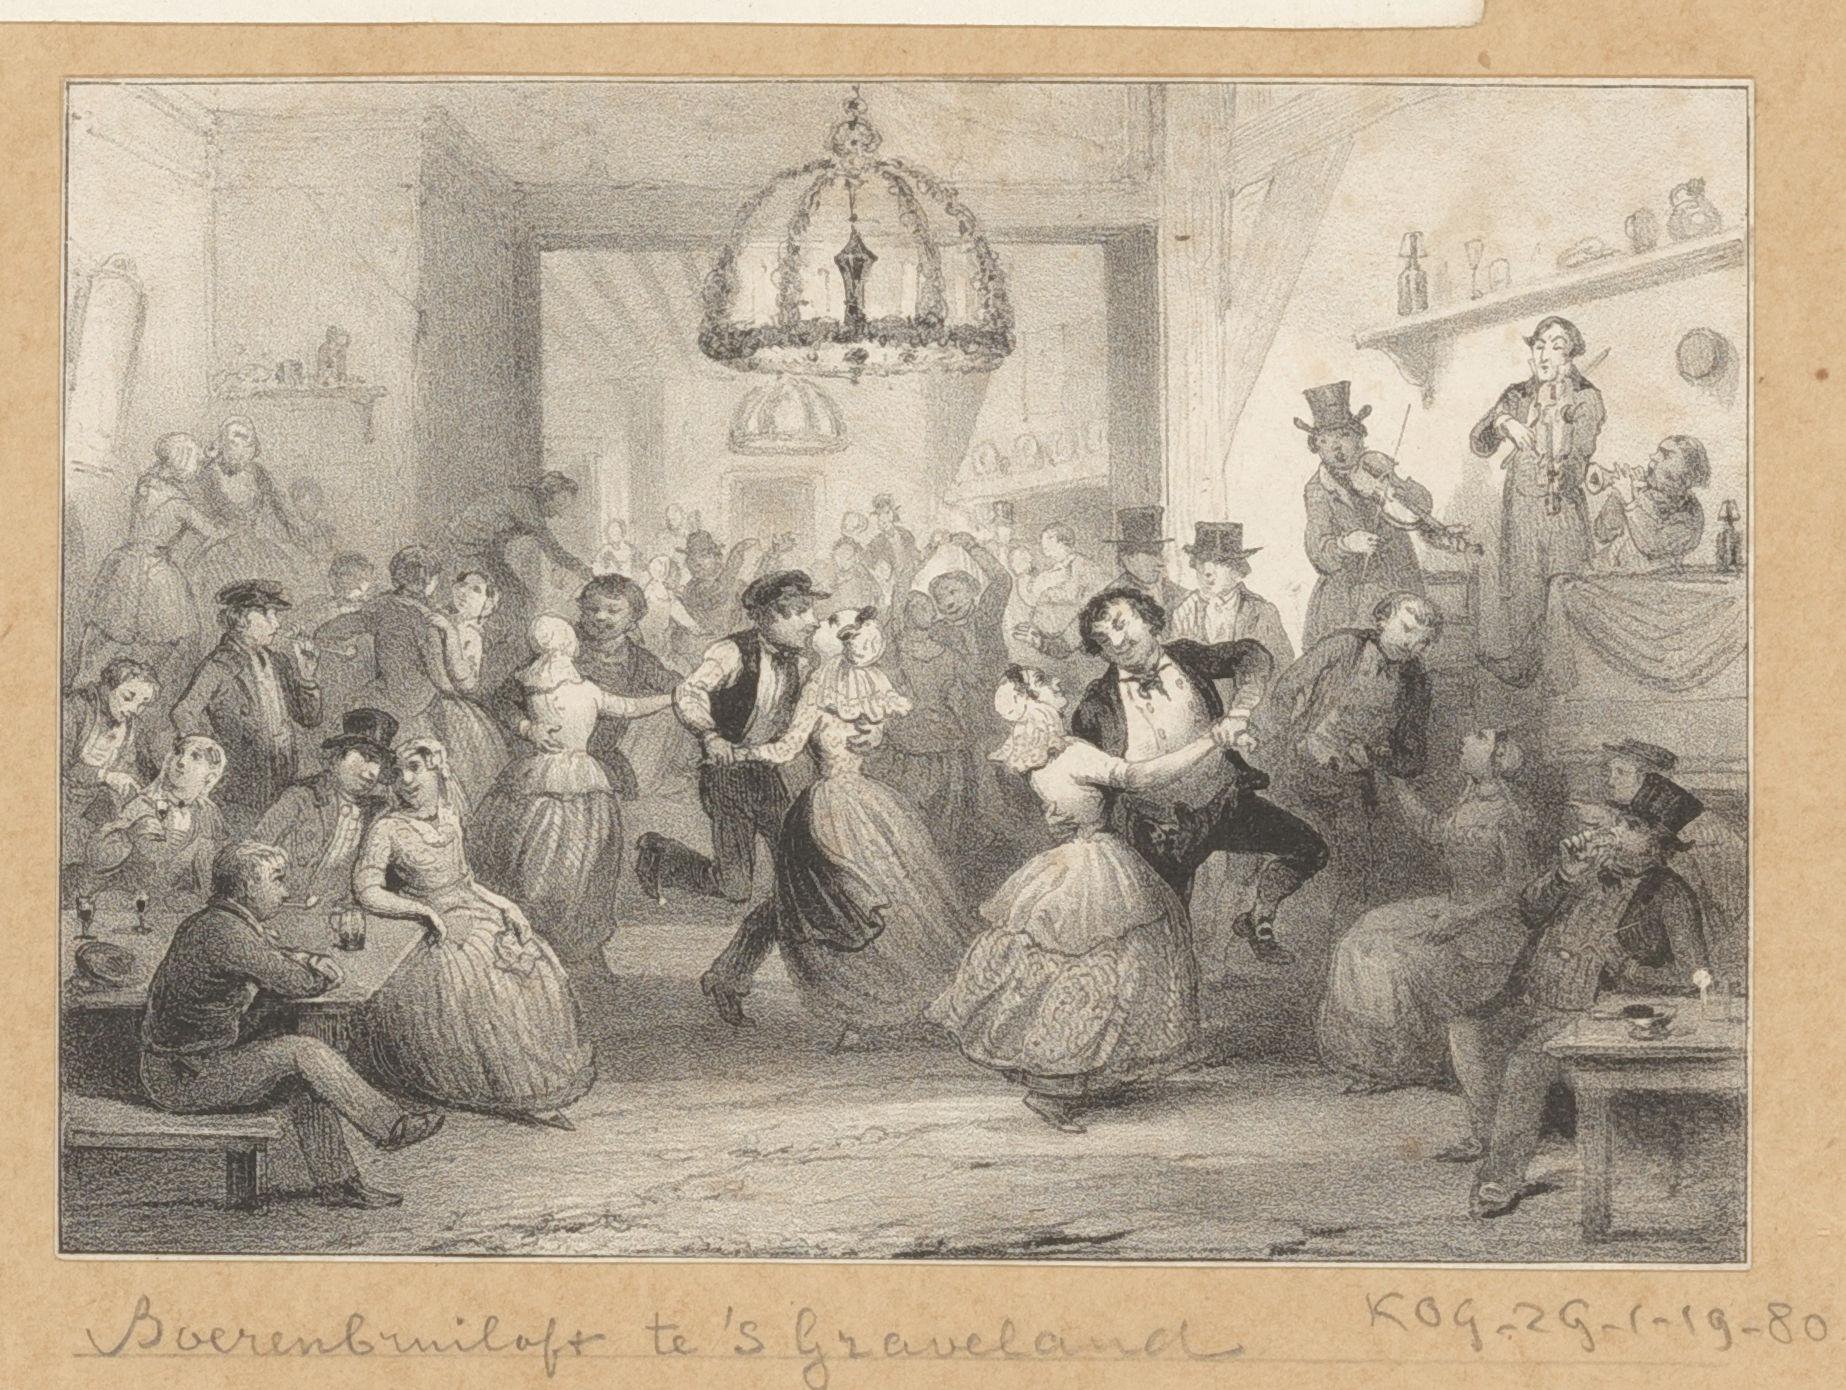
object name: print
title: Boerenbruiloft te 's-Graveland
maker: Anonymous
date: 1850-1900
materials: paper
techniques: lithograph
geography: netherlands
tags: dancing at wedding feast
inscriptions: collector's mark: Lugt 1641, collector's mark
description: Boerenbruiloftsfeest te 's-Graveland. Centraal dansende paren, rechts muzikanten. Onderwerpsrubrieken binnen de Atlas Zeden en Gewoonten: Des Menschen Begin, Midden en Einde. Bruiloft en huwelijk.